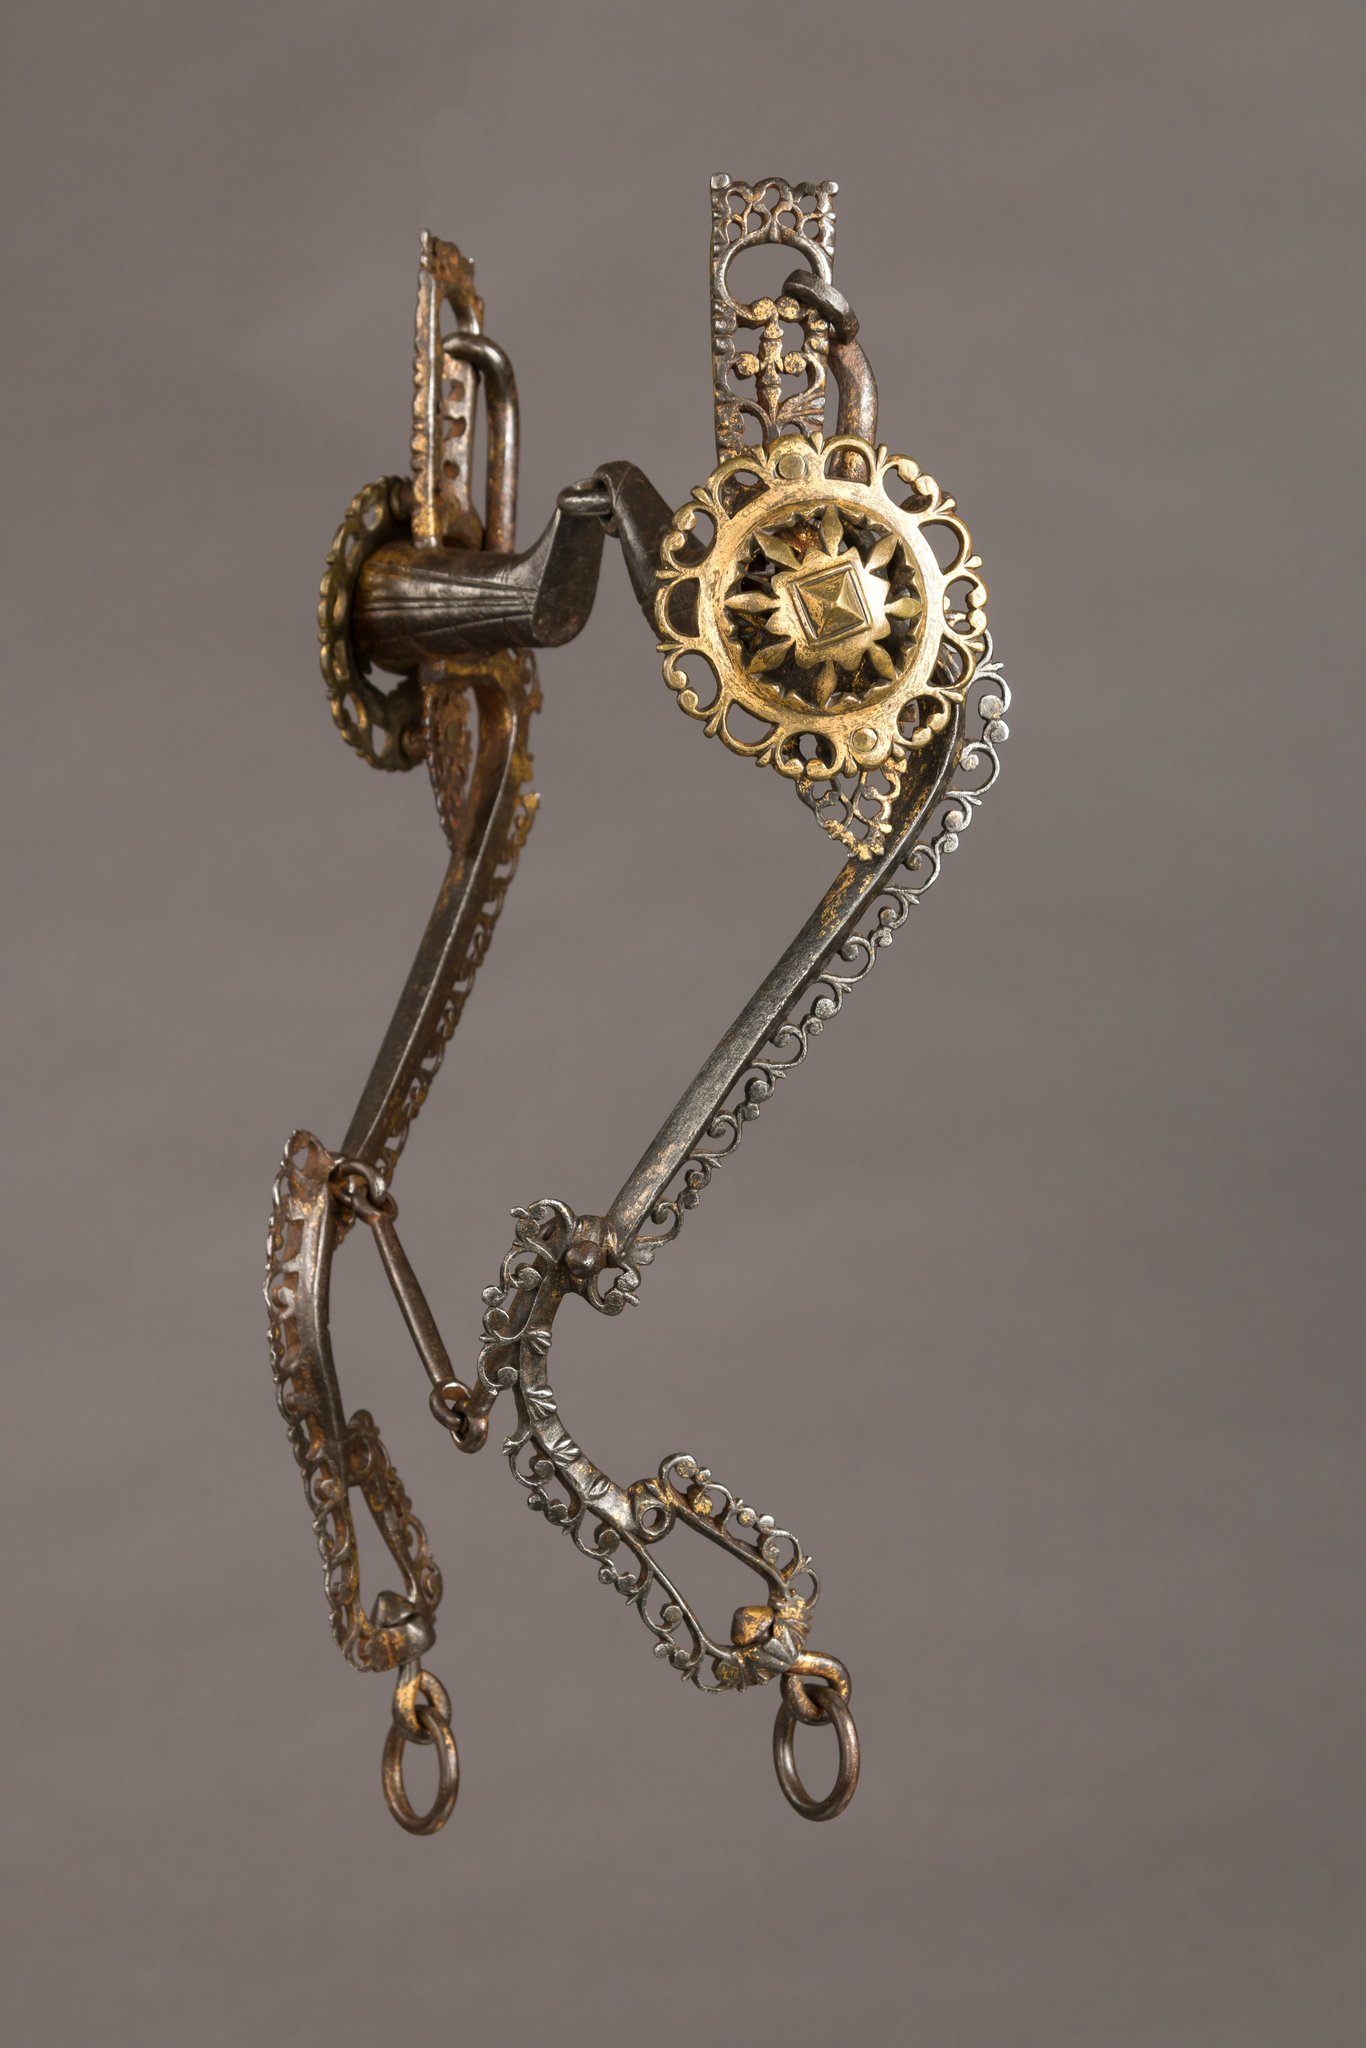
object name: bit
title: Curb Bit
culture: german, south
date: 1601-1700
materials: copper alloy, gold, metal alloy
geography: germany